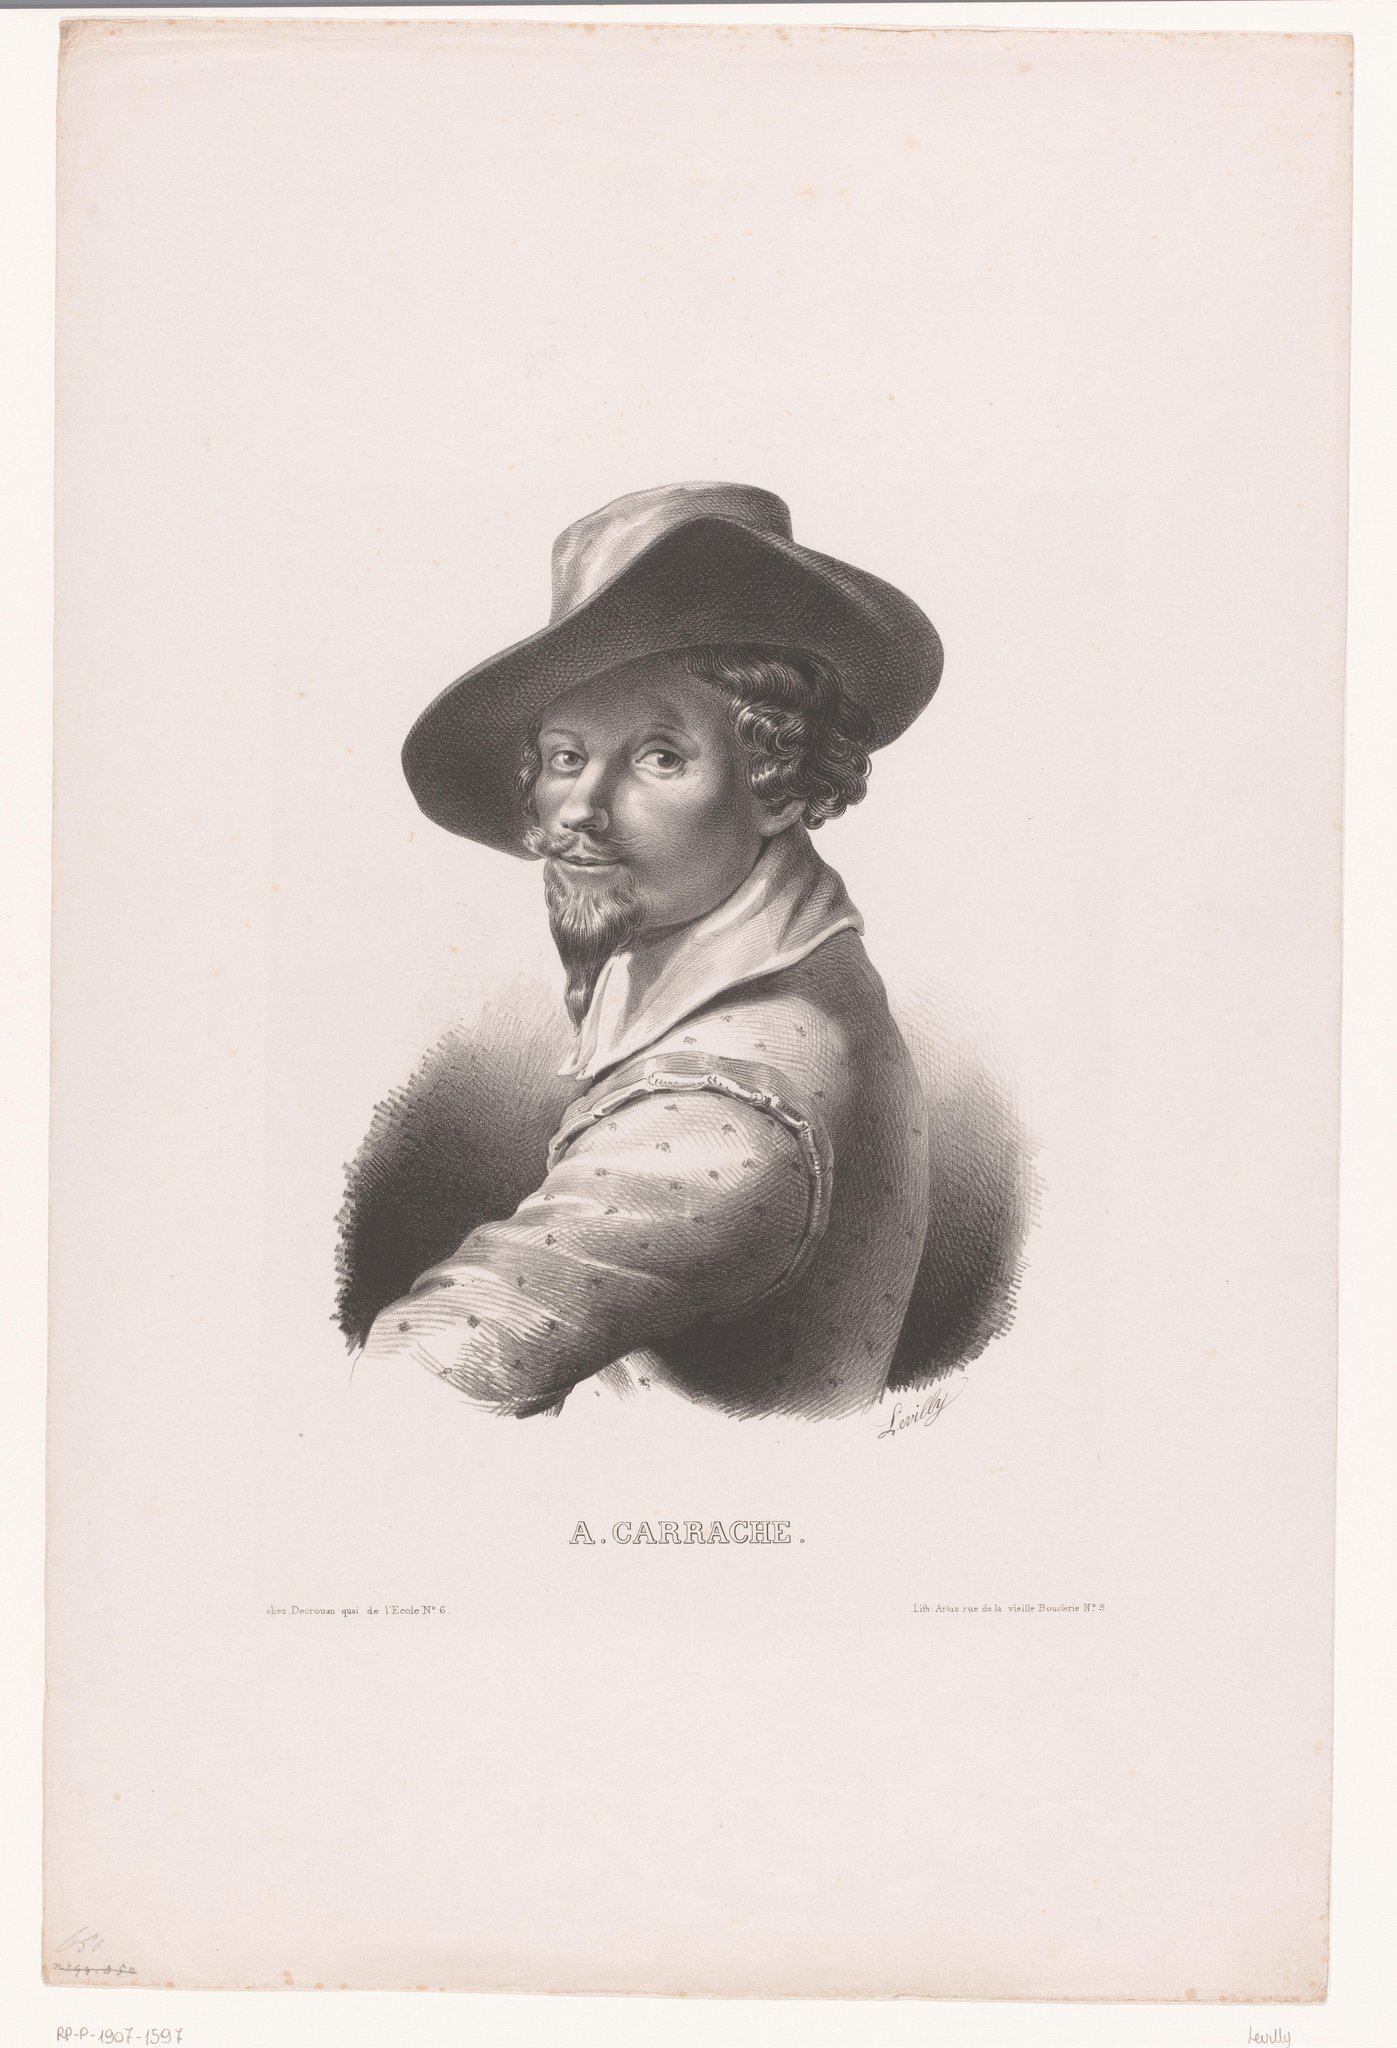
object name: print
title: A. Carrache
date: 1837-1839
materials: paper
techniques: lithograph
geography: paris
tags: annibale carracci, historical persons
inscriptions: collector's mark: Lugt 2228